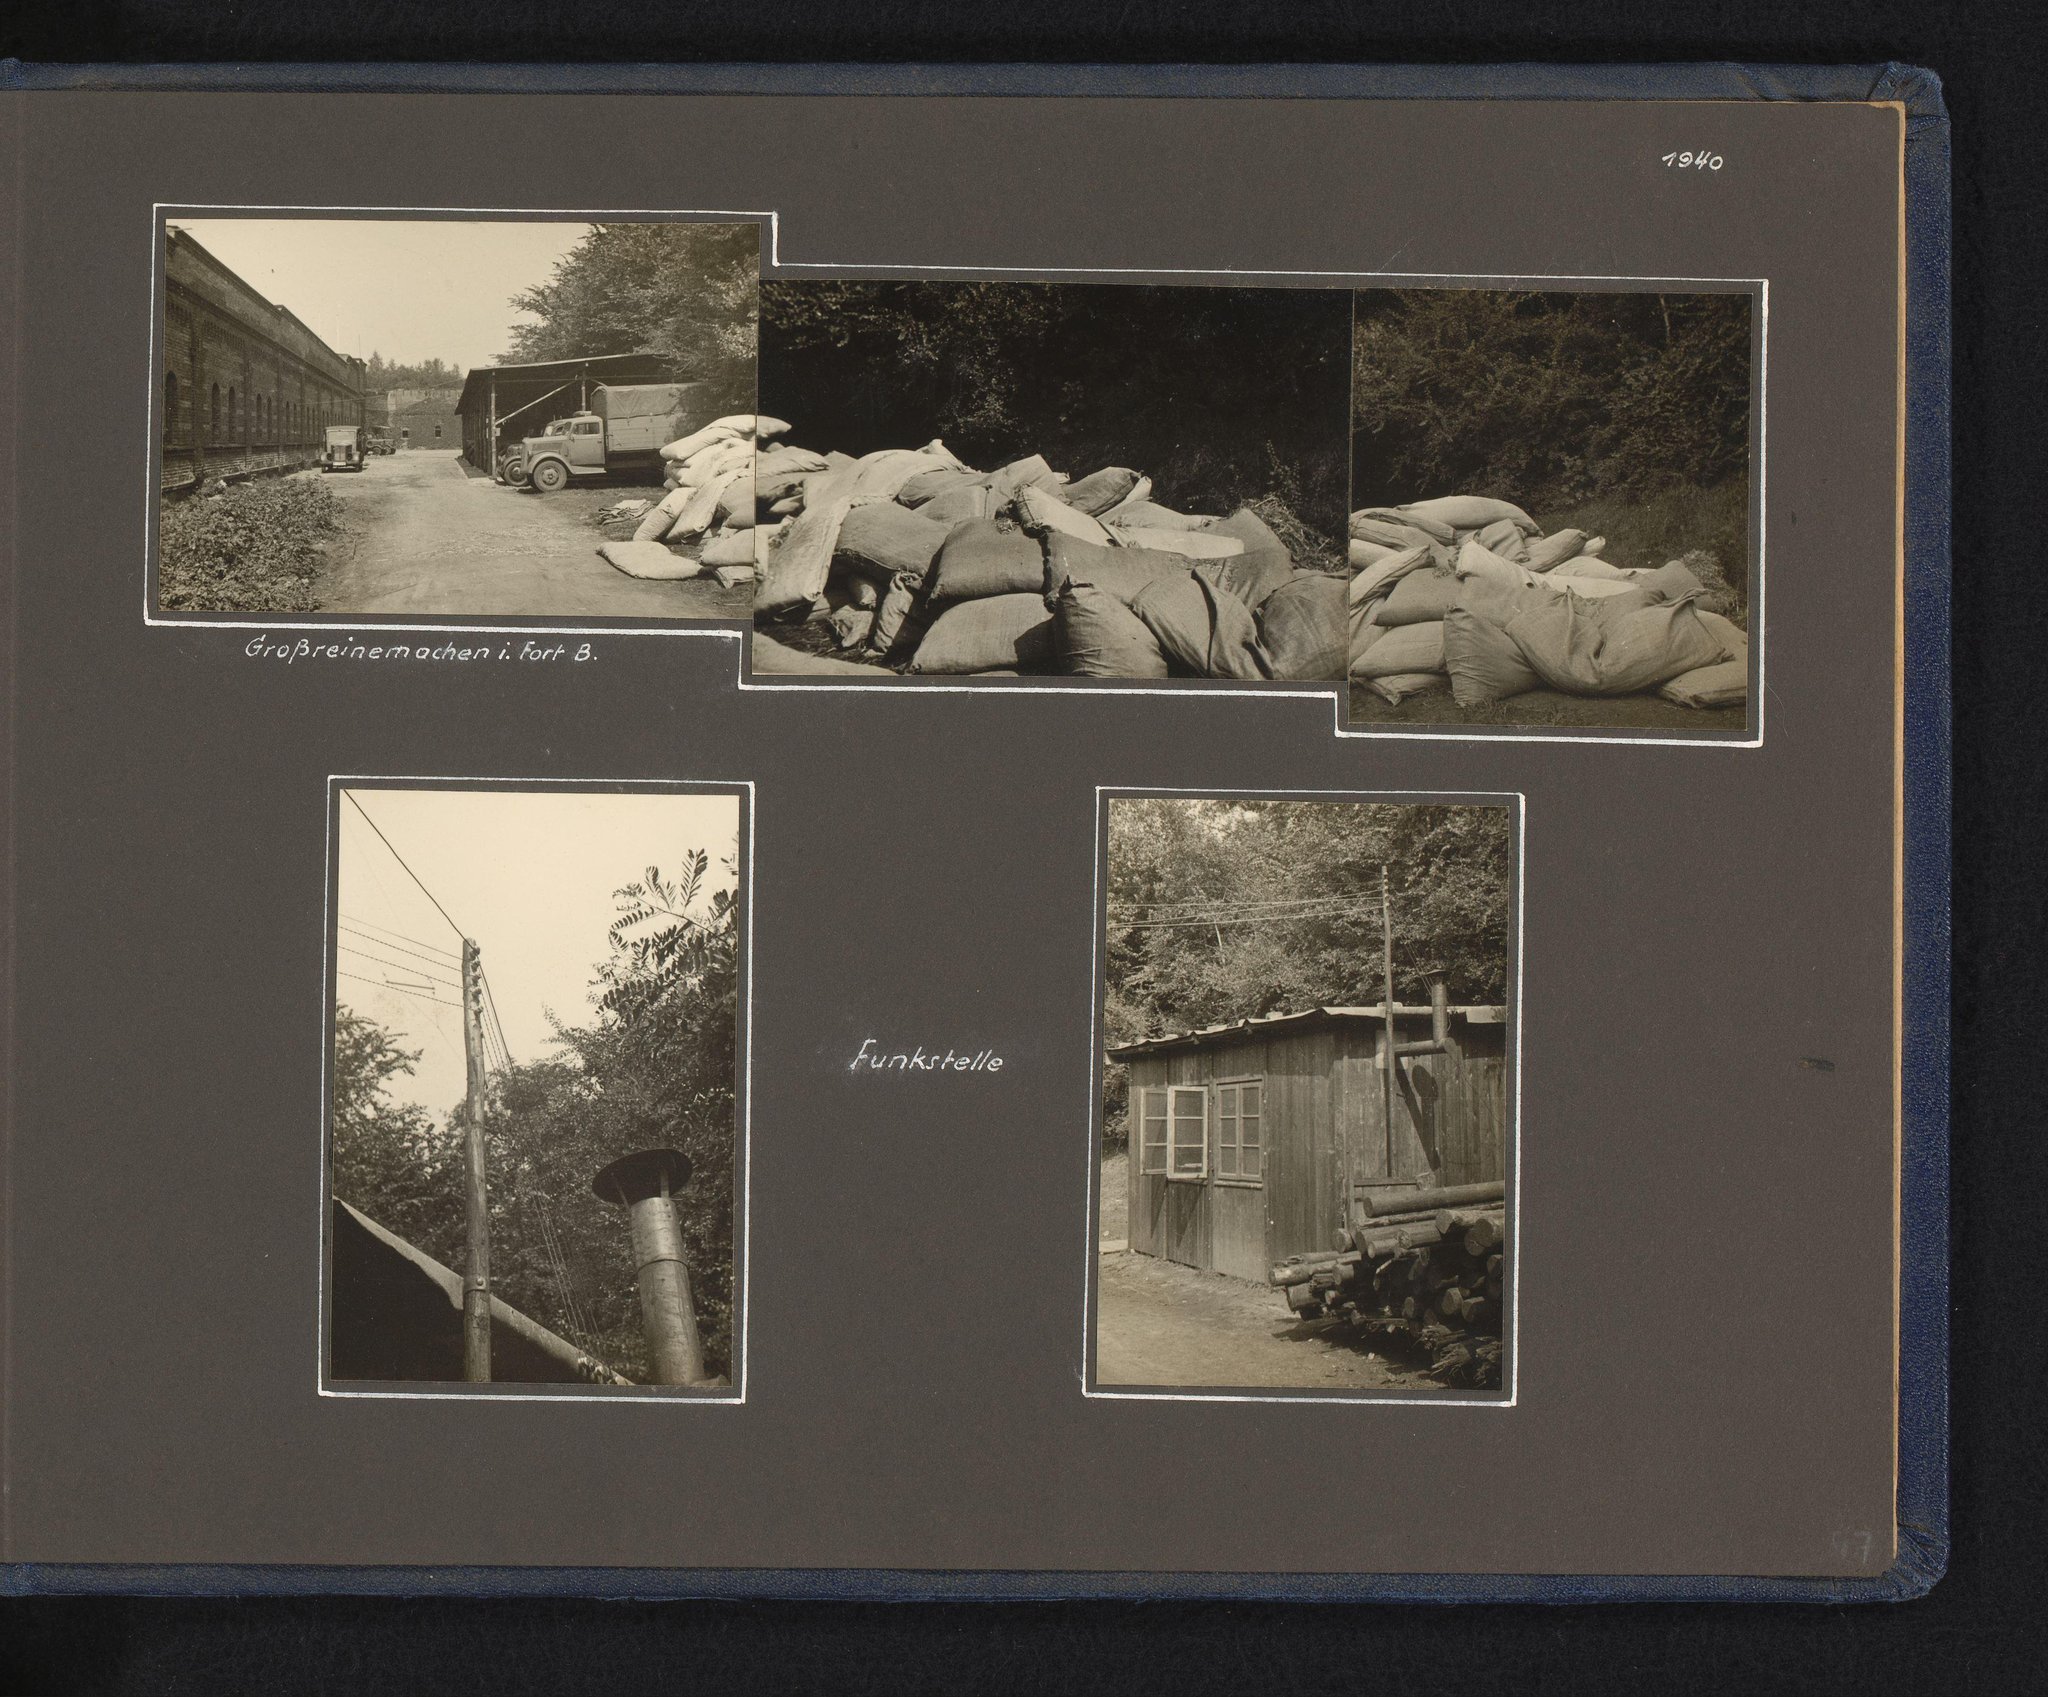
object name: photograph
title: Fort Bocklemünd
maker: Anonymous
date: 1940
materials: paper, photographic support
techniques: gelatin silver print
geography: germany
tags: communication (military), radiotelegraph, walkie-talkie, germany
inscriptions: inscription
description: Albumblad met twee foto's en een collage bestaande uit drie foto's van Fort Bocklemünd (Keulen) in 1940. De collage geeft een beeld van een grote schoonmaak in het fort, de andere twee van de zendinstallatie (Funkstelle). Onderdeel van een Duits militair album Tweede Wereldoorlog 1939-1940.